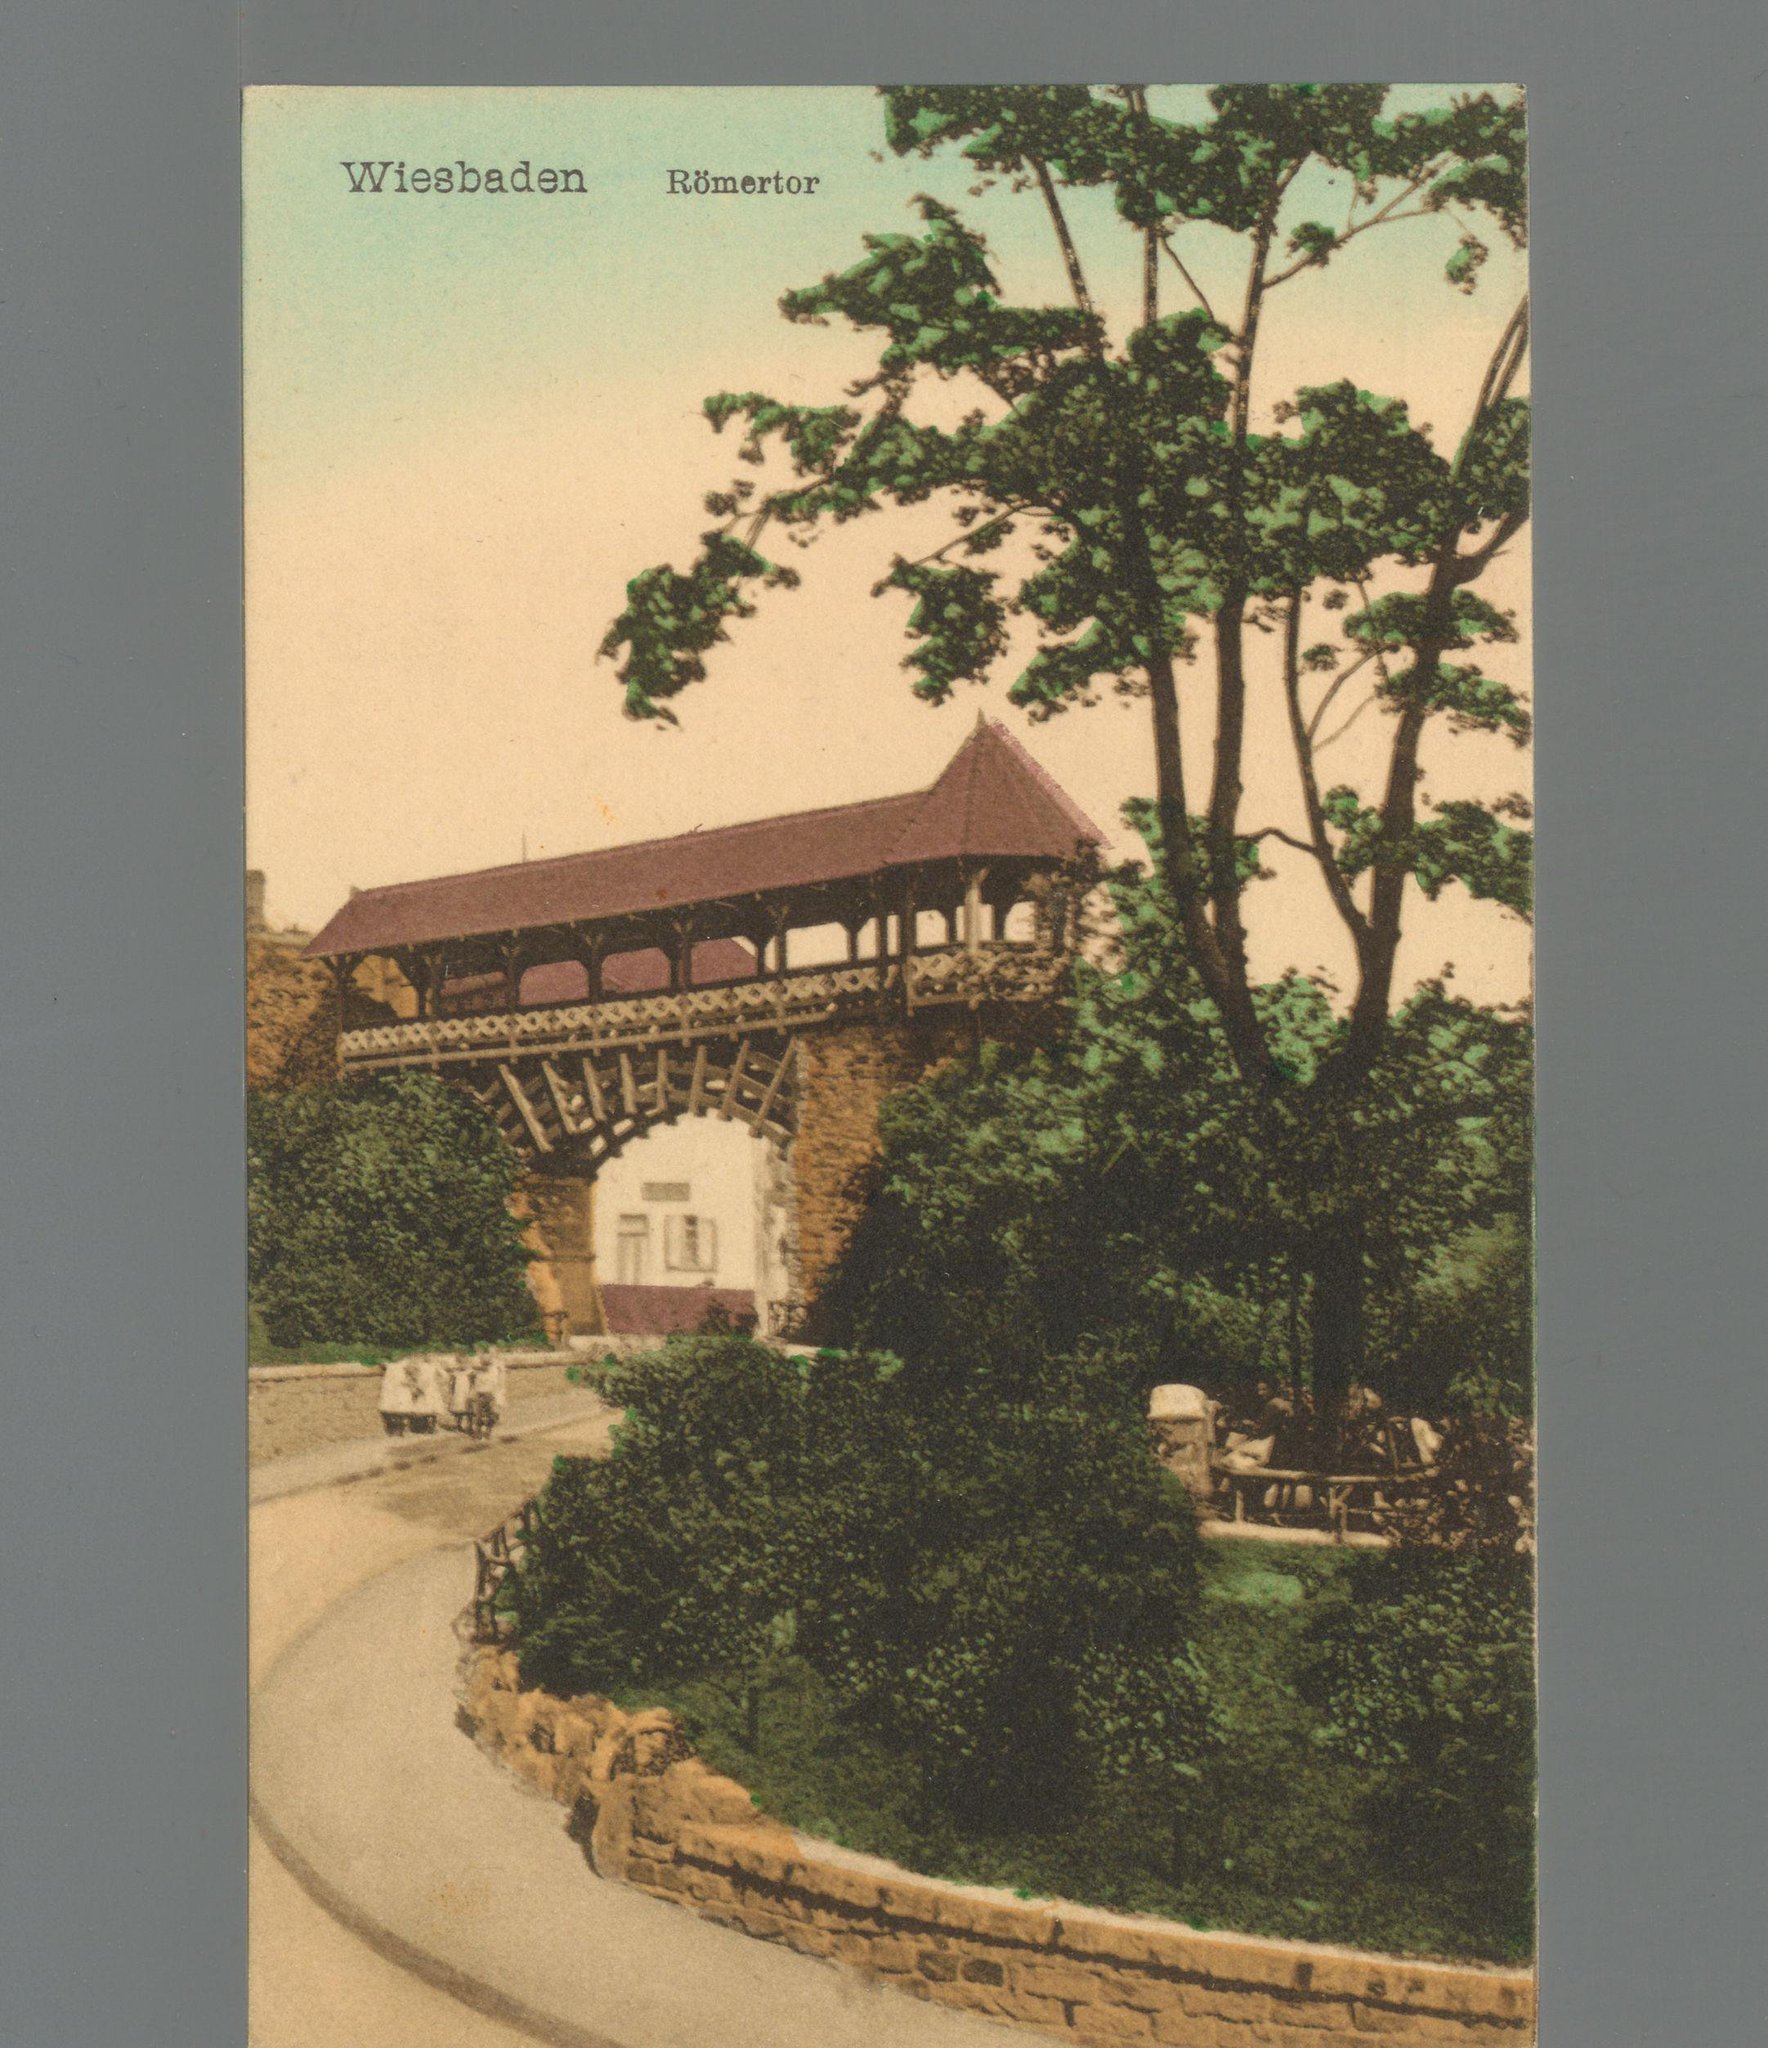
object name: photomechanical print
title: Wiesbaden. Römertor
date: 1908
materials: cardboard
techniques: photograph, lithograph, writing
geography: wiesbaden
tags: city-gate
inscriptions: date